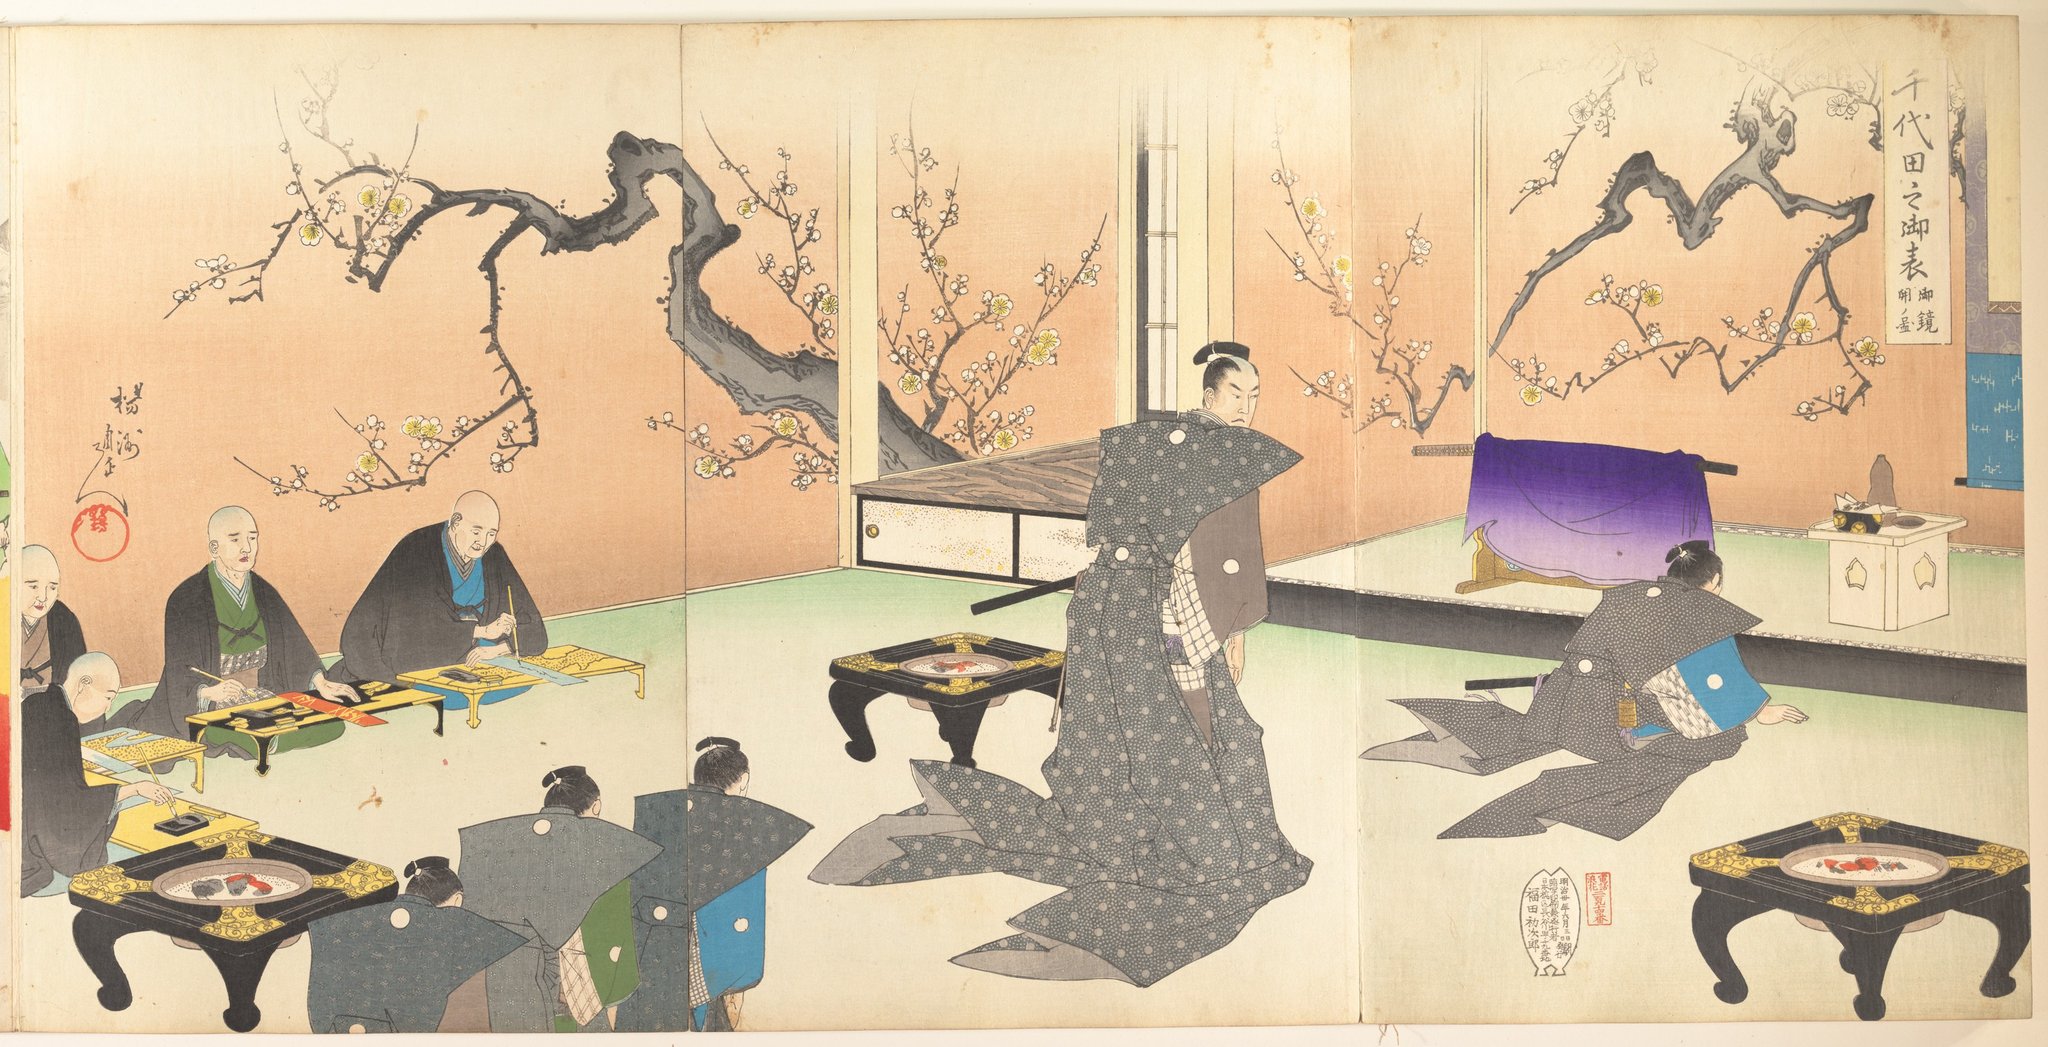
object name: print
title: Chiyoda Castle (Album of Men)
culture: japanese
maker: yōshū (hashimoto) chikanobu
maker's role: artist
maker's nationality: japanese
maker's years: 1838-1912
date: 1897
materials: ink, paper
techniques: woodblock print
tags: painting,men,writing